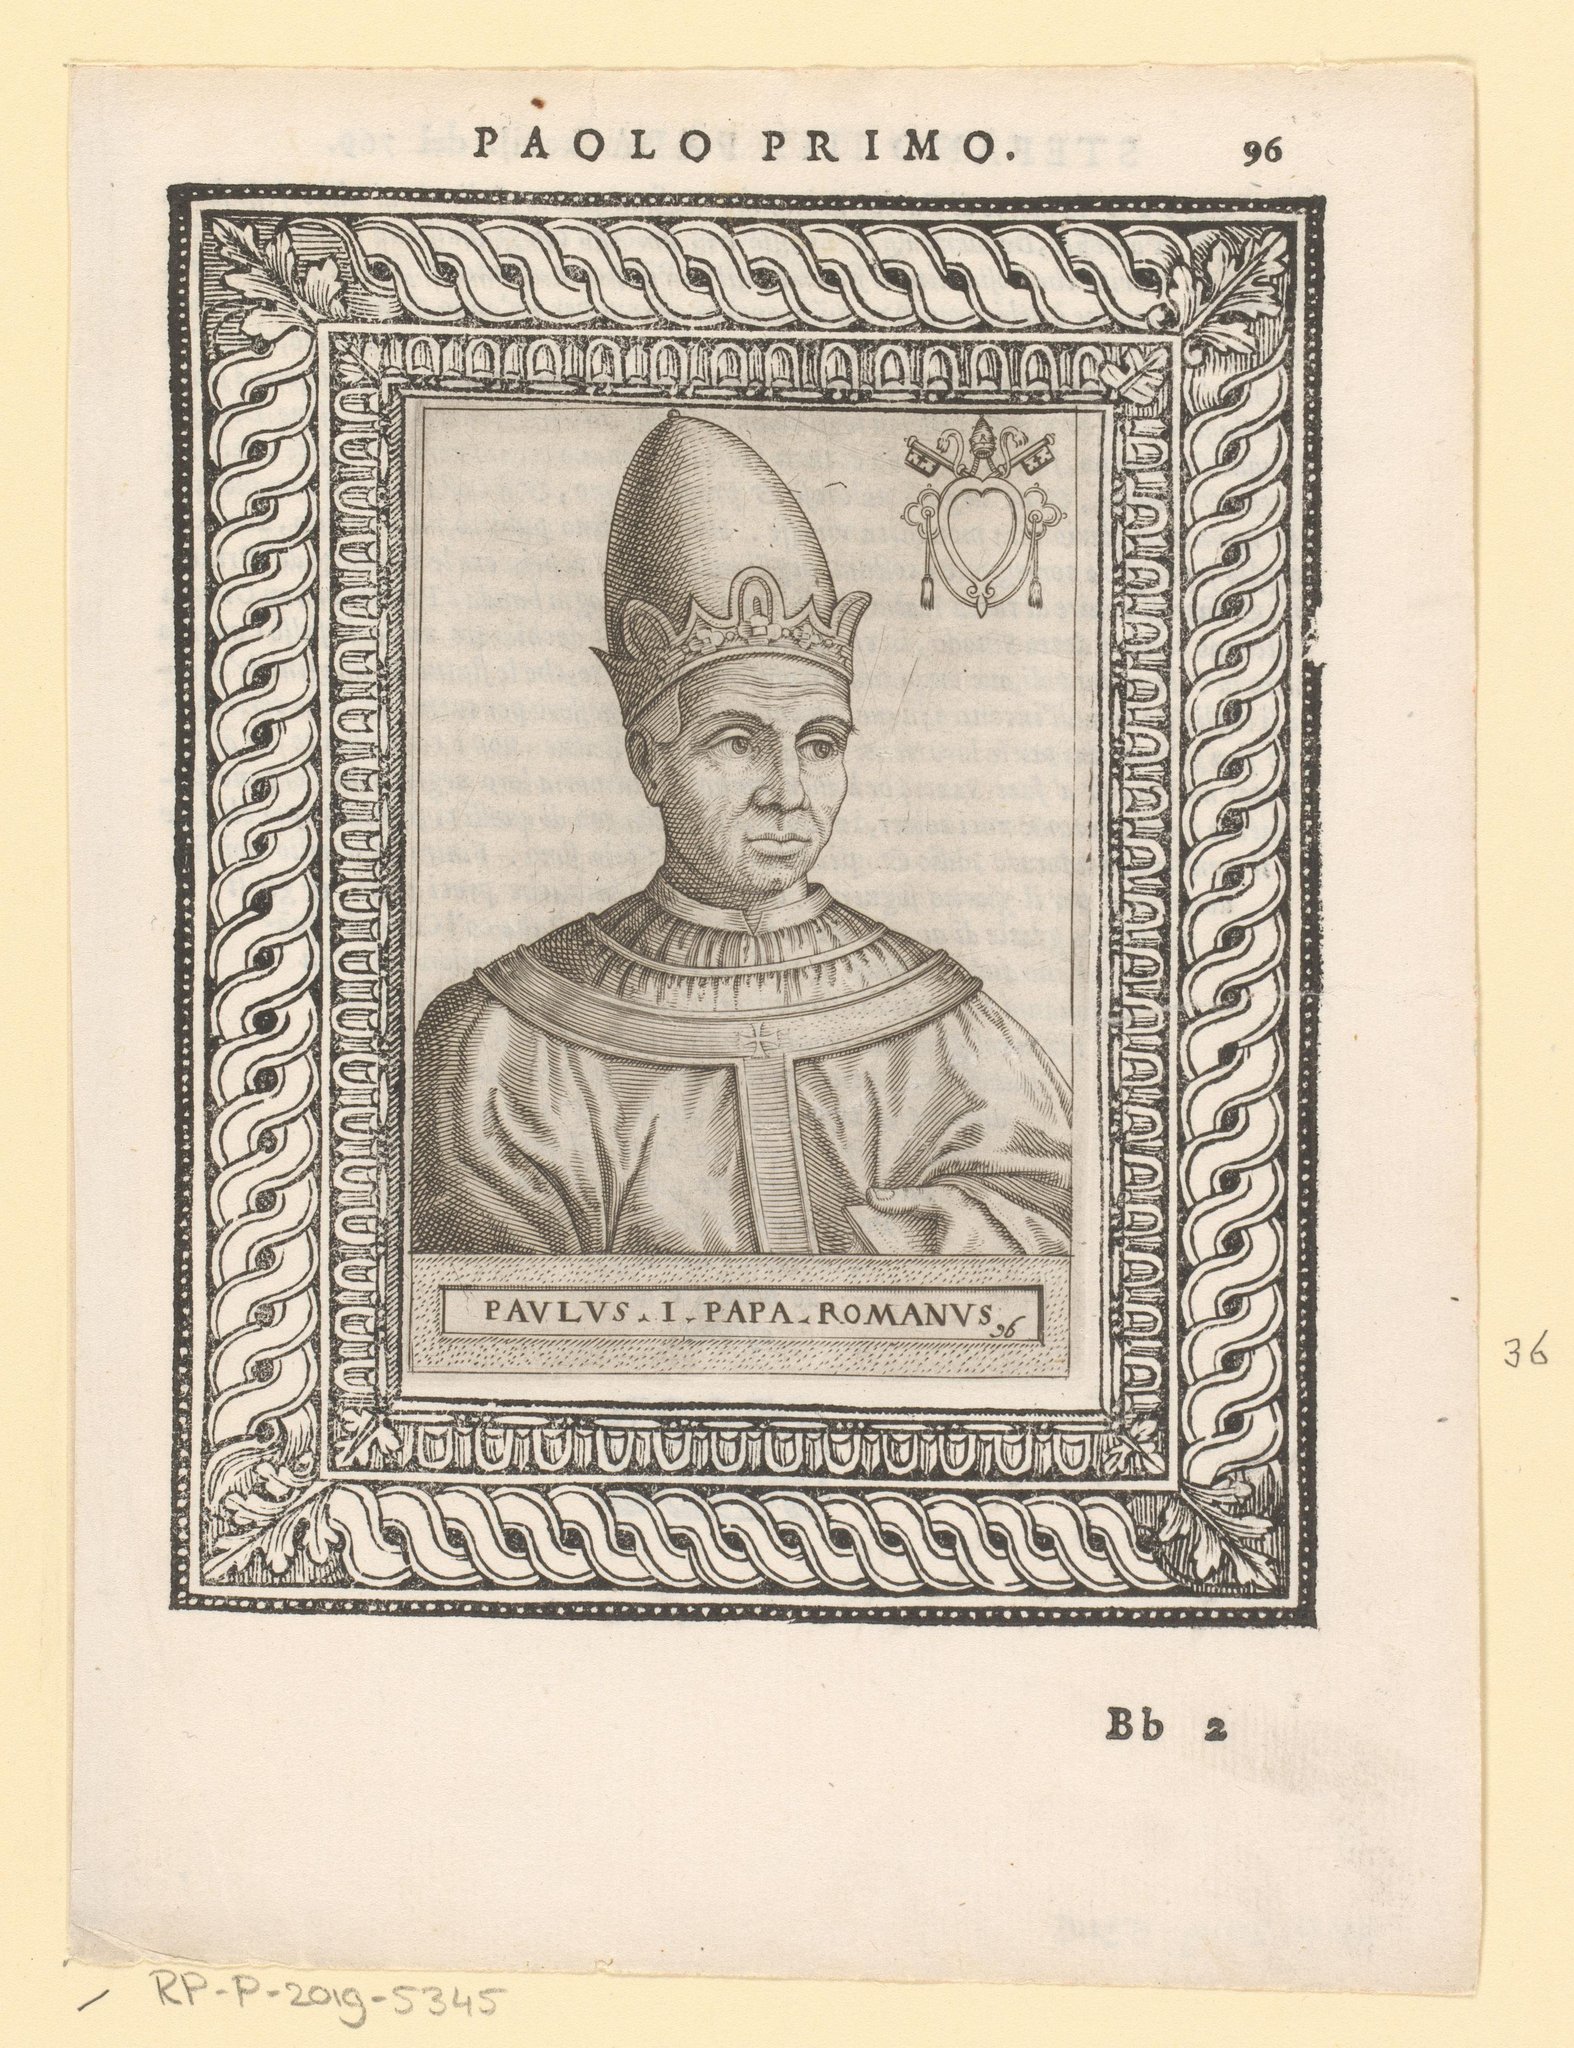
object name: print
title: Paulus I Papa Romanus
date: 1587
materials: paper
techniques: engraving, letterpress printing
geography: rome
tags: historical persons, pope, armorial bearing, heraldry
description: Prent uit: Ciccarelli, Antonio. Le vite de Pontefici di Antonio Ciccarelli (...). Rome: Domenico Basa, 1587. Prent voor het eerst verschenen in: Cavalieri, Giovanni Battista de'. Pontificum romanorum effigies (...). Rome: Domenico Basa en Francesco Zanetti, 1580. Prent ook gebruikt in latere publicaties.